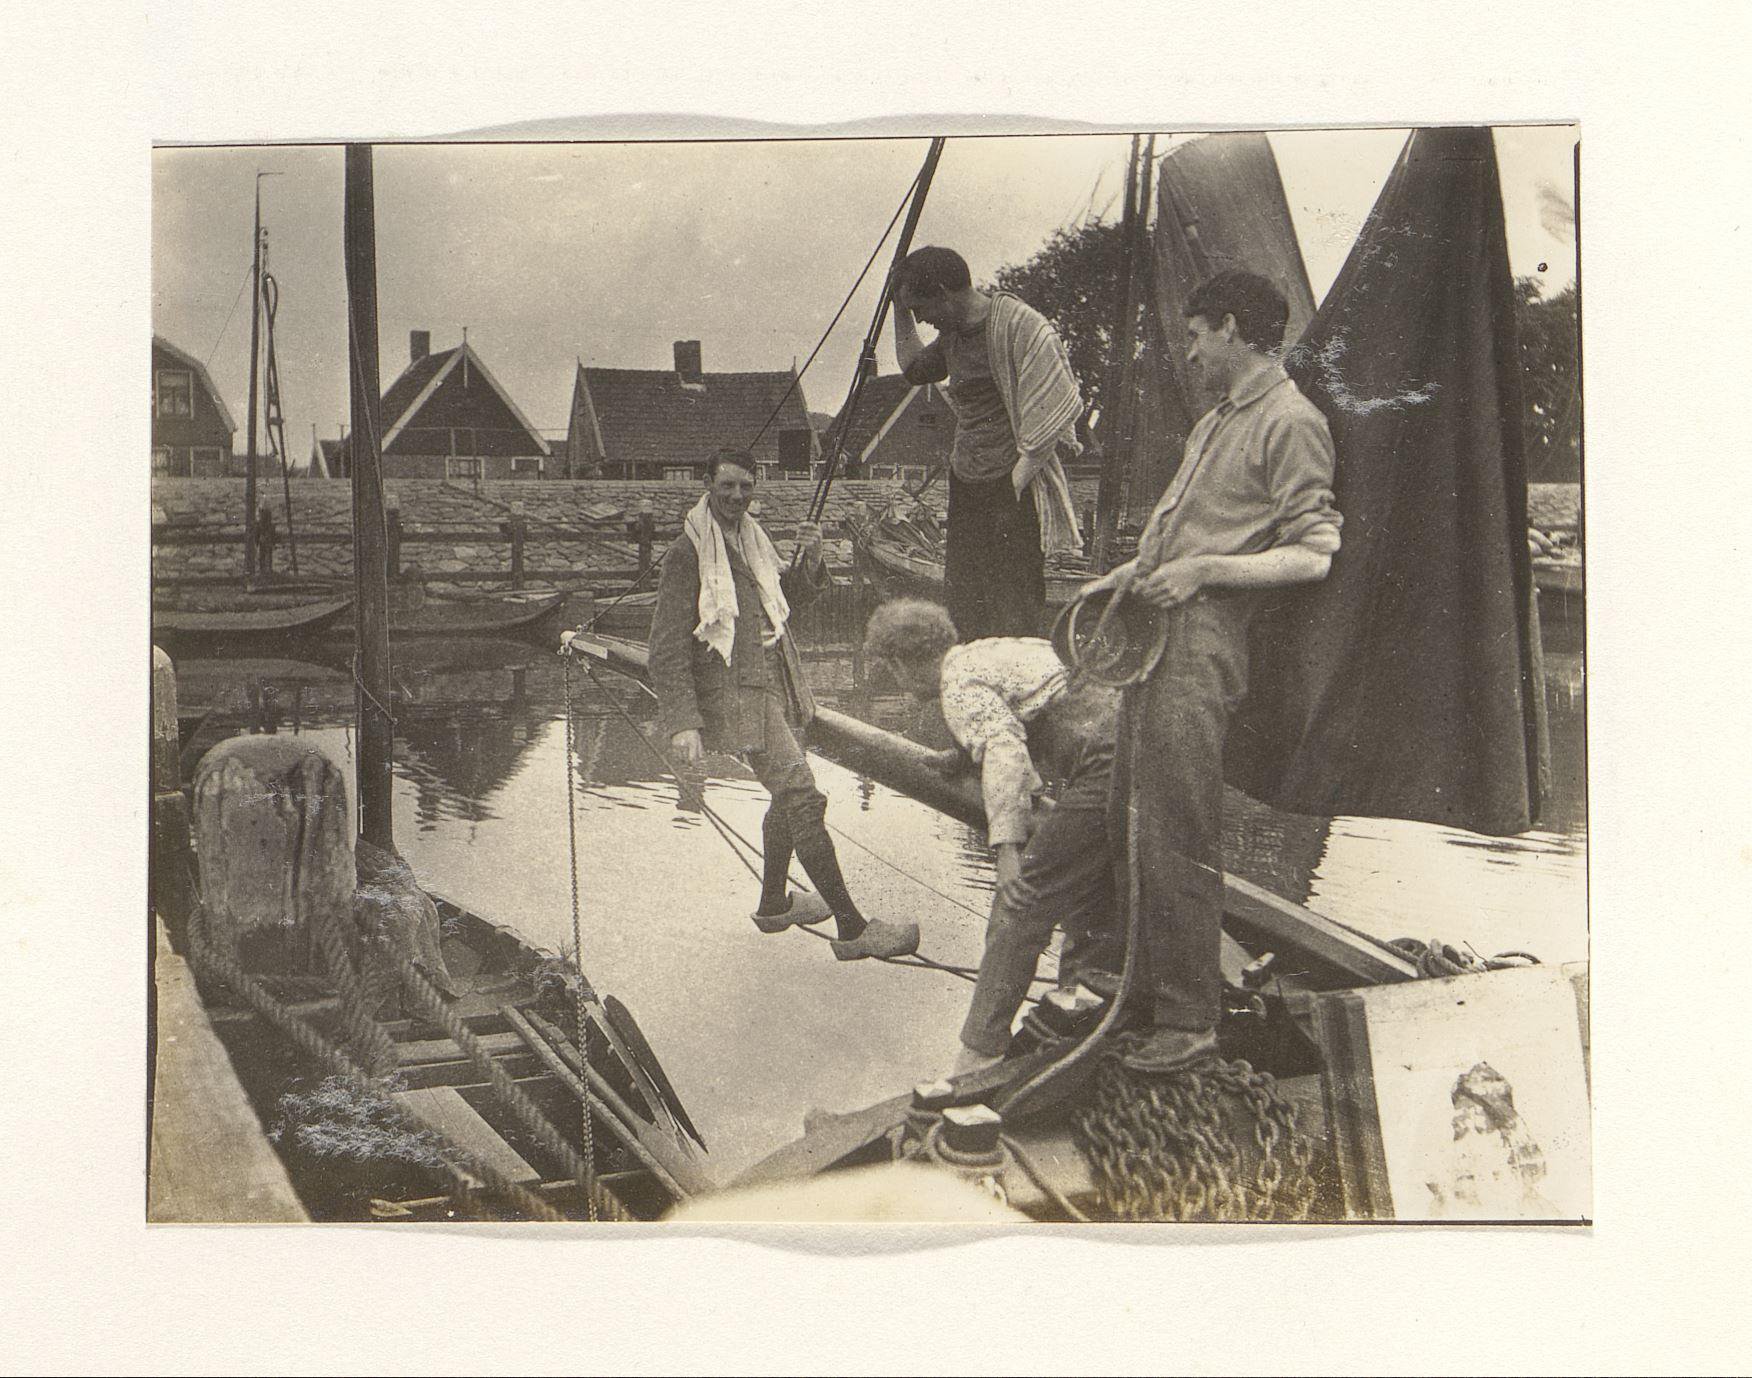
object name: photograph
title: Mannen op een aangemeerde boot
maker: george hidderley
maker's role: fotograaf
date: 1900-1910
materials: paper, photographic support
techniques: gelatin silver print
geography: volendam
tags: sailing-ship, sailing-boat, adult man, historical persons